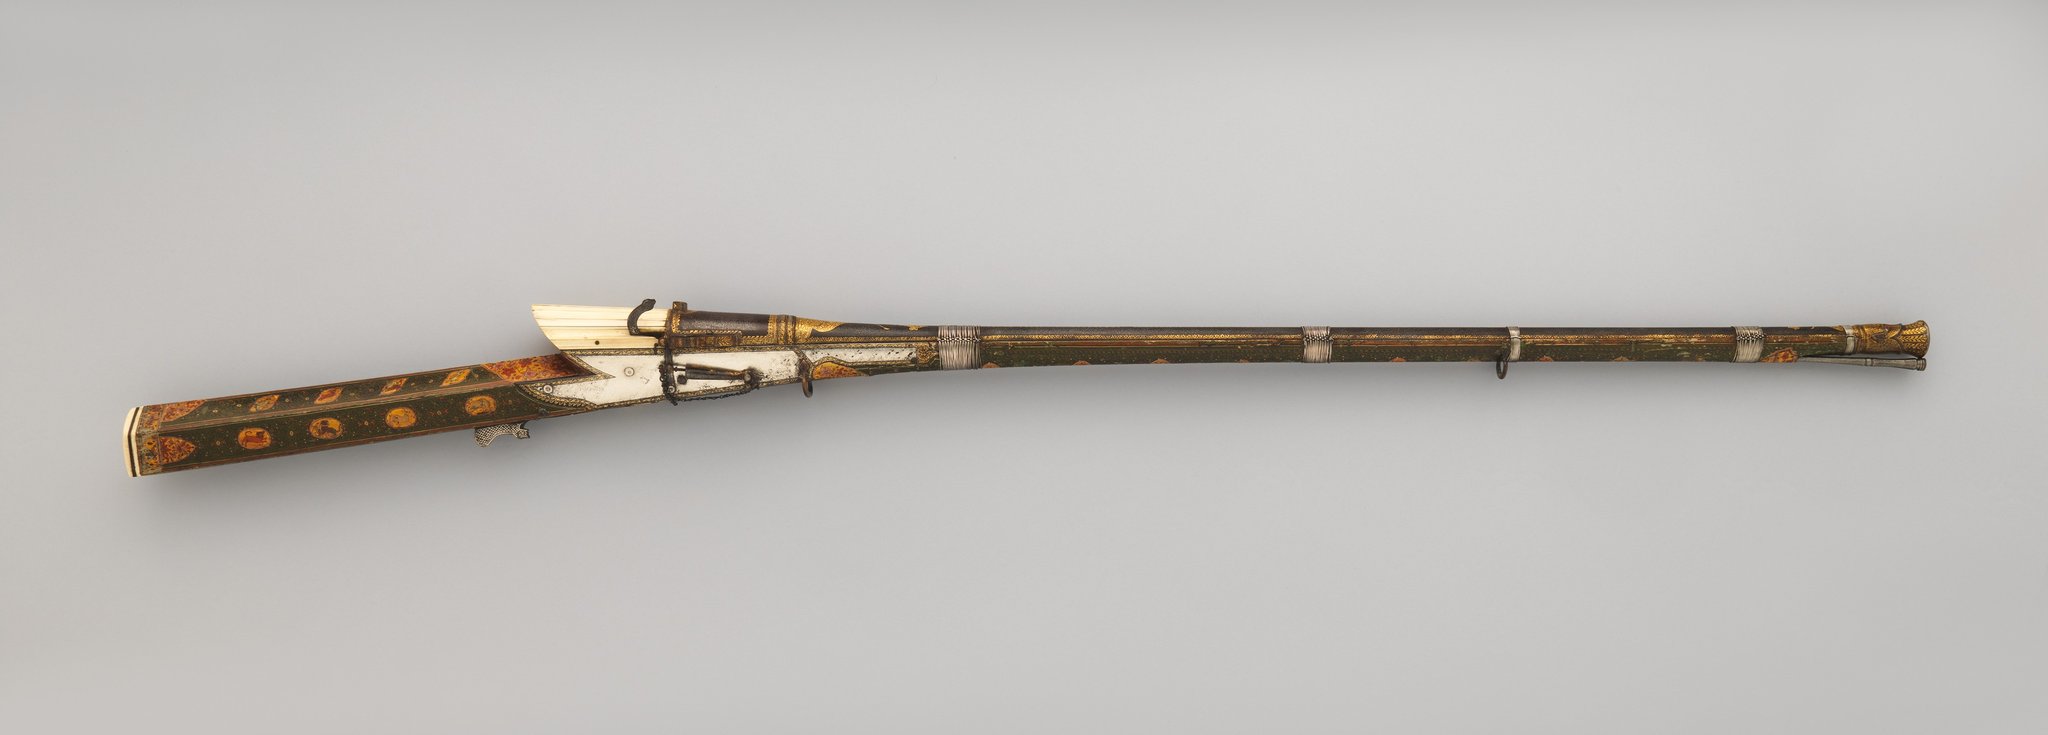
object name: matchlock gun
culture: indian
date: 1767-1900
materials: copper alloy, gold, iron, ivory, pigment, silver, steel, wood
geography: india